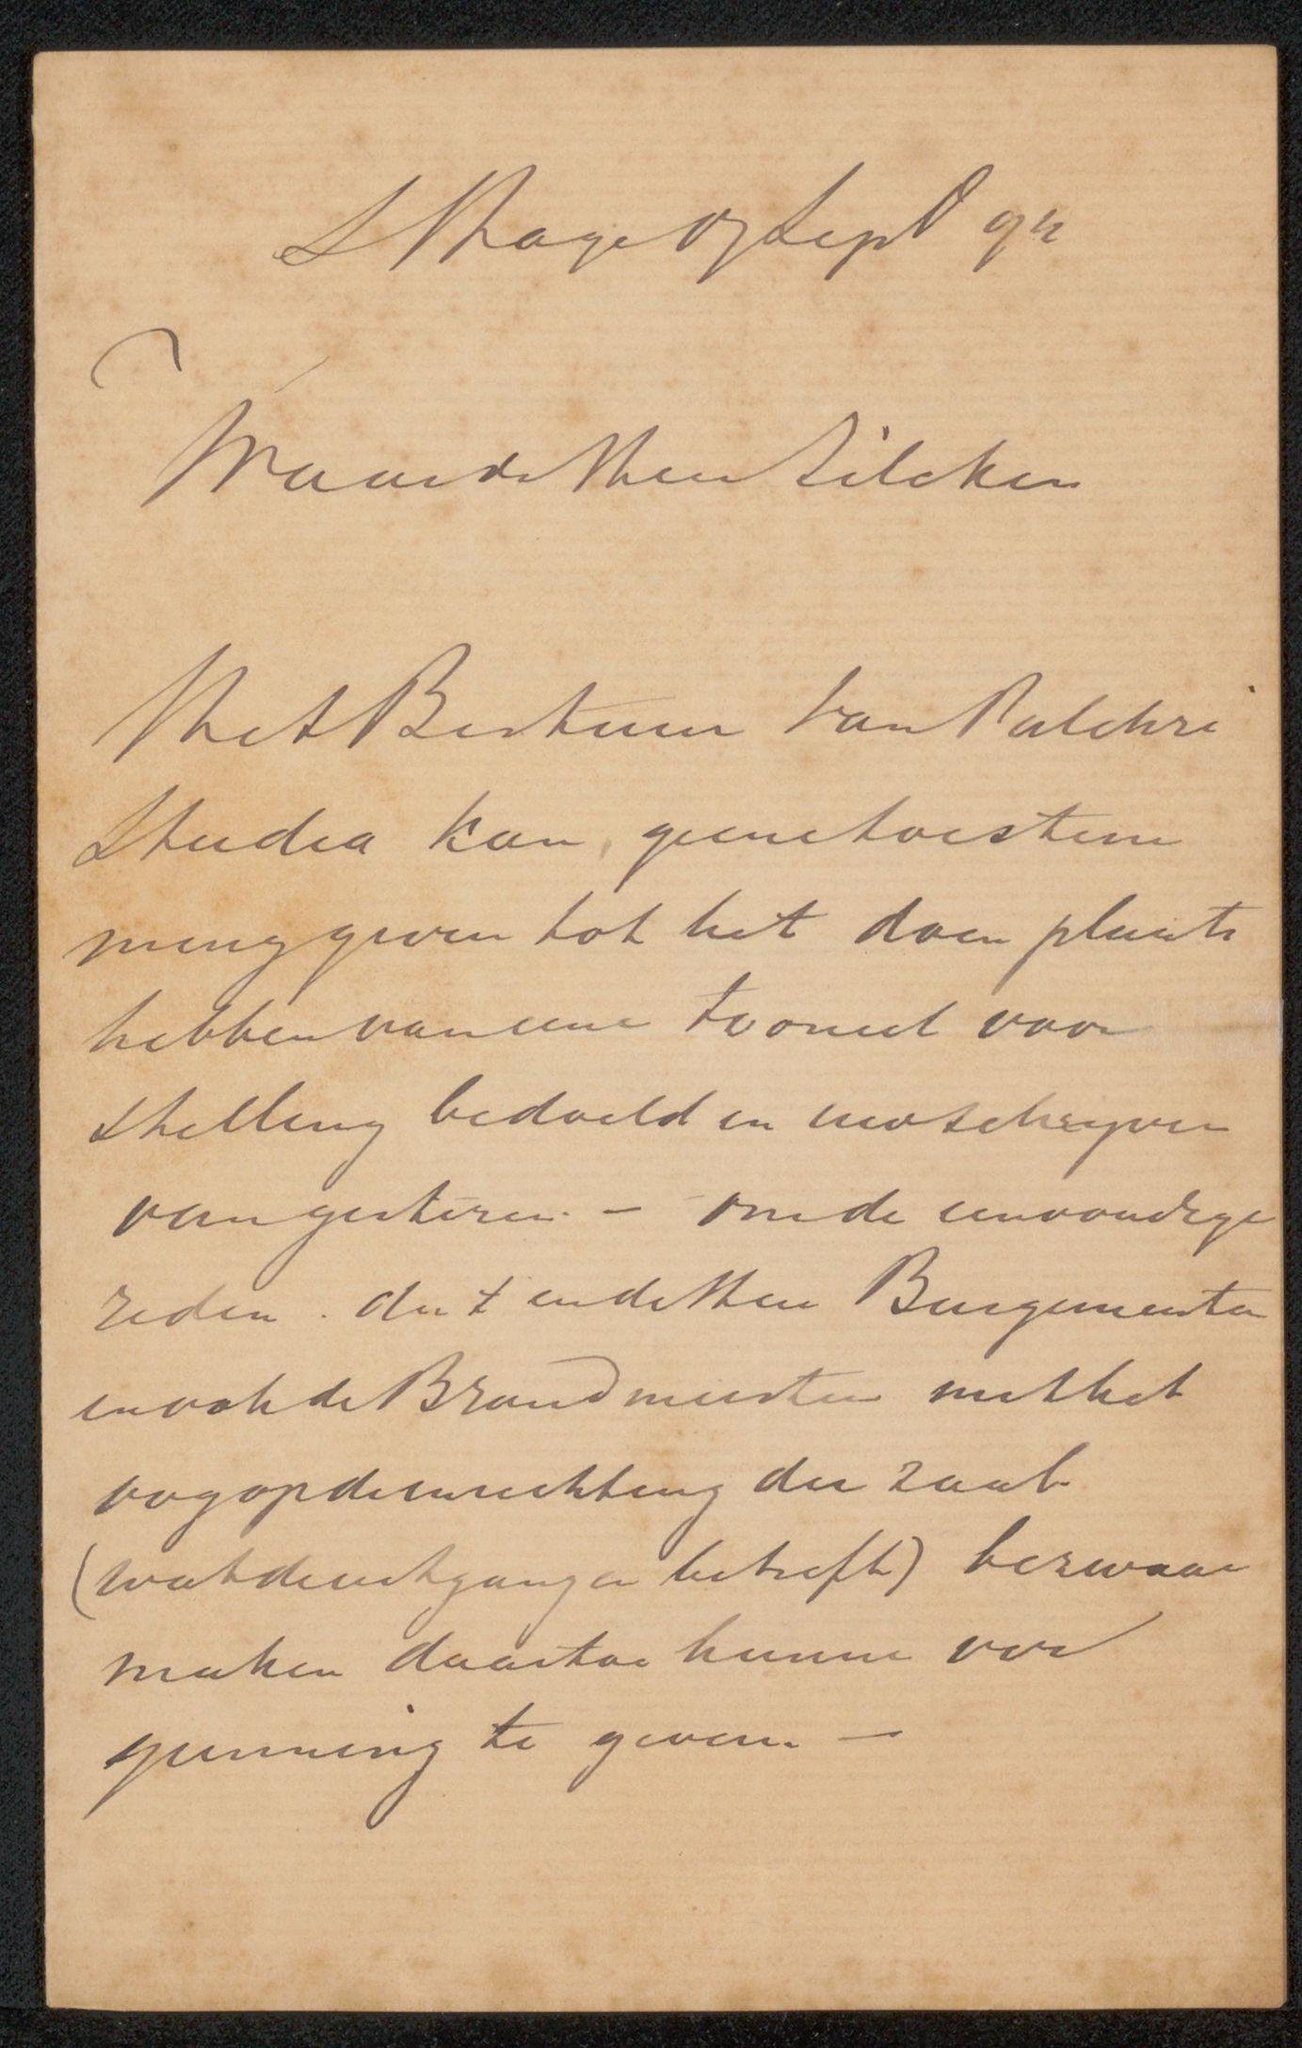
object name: letter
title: Brief aan Philip Zilcken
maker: hendrik willem mesdag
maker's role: draughtsman, painter, print maker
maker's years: 1831-1915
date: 1894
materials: ink, paper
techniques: pen, writing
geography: the hague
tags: painter, draughtsman, philip zilcken, the arts of the stage: ballet, theatre, musical drama, motion picture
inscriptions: watermark